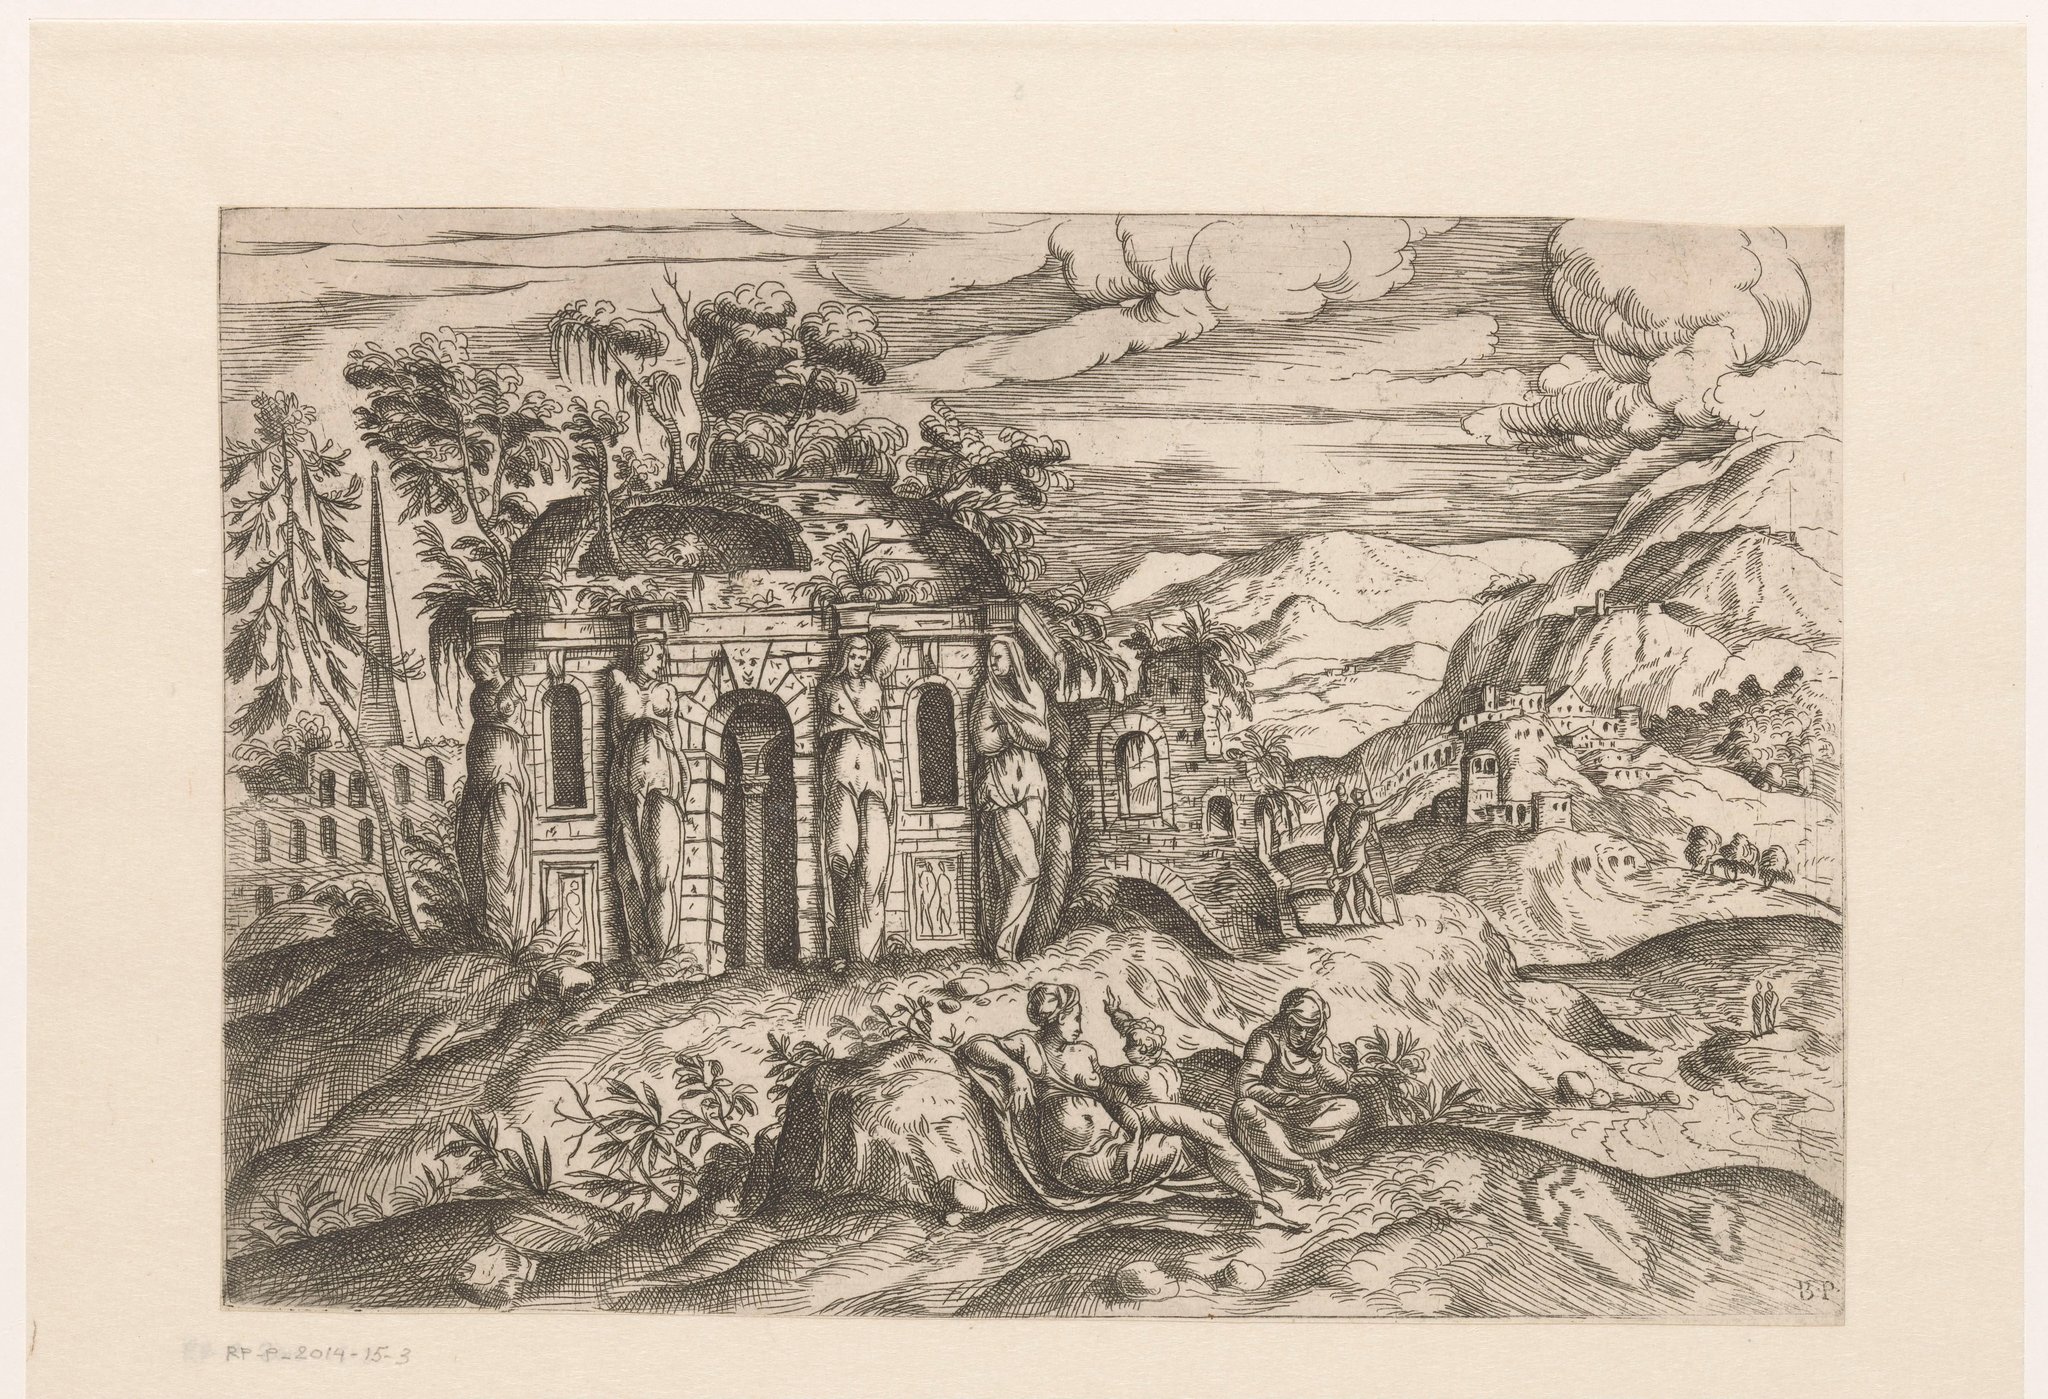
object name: print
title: Landschap met ruïnes en fantasie-architectuur en twee vrouwen met kind op de voorgrond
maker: giovanni battista pittoni (i)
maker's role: print maker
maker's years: 1520-1583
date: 1560-1570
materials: paper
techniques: etching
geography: vicenza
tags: fantastic architecture, unrealistic architectural fantasies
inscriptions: collector's mark: Lugt 2228, collector's mark: Lugt 2760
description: Vermoedelijk is deze prentreeks onbeschreven (vergelijk Passavant, deel 6 p. 169-170, nr. 1). Het is vooralsnog onduidelijk of de reeks compleet is of wellicht uit meer prenten bestond.